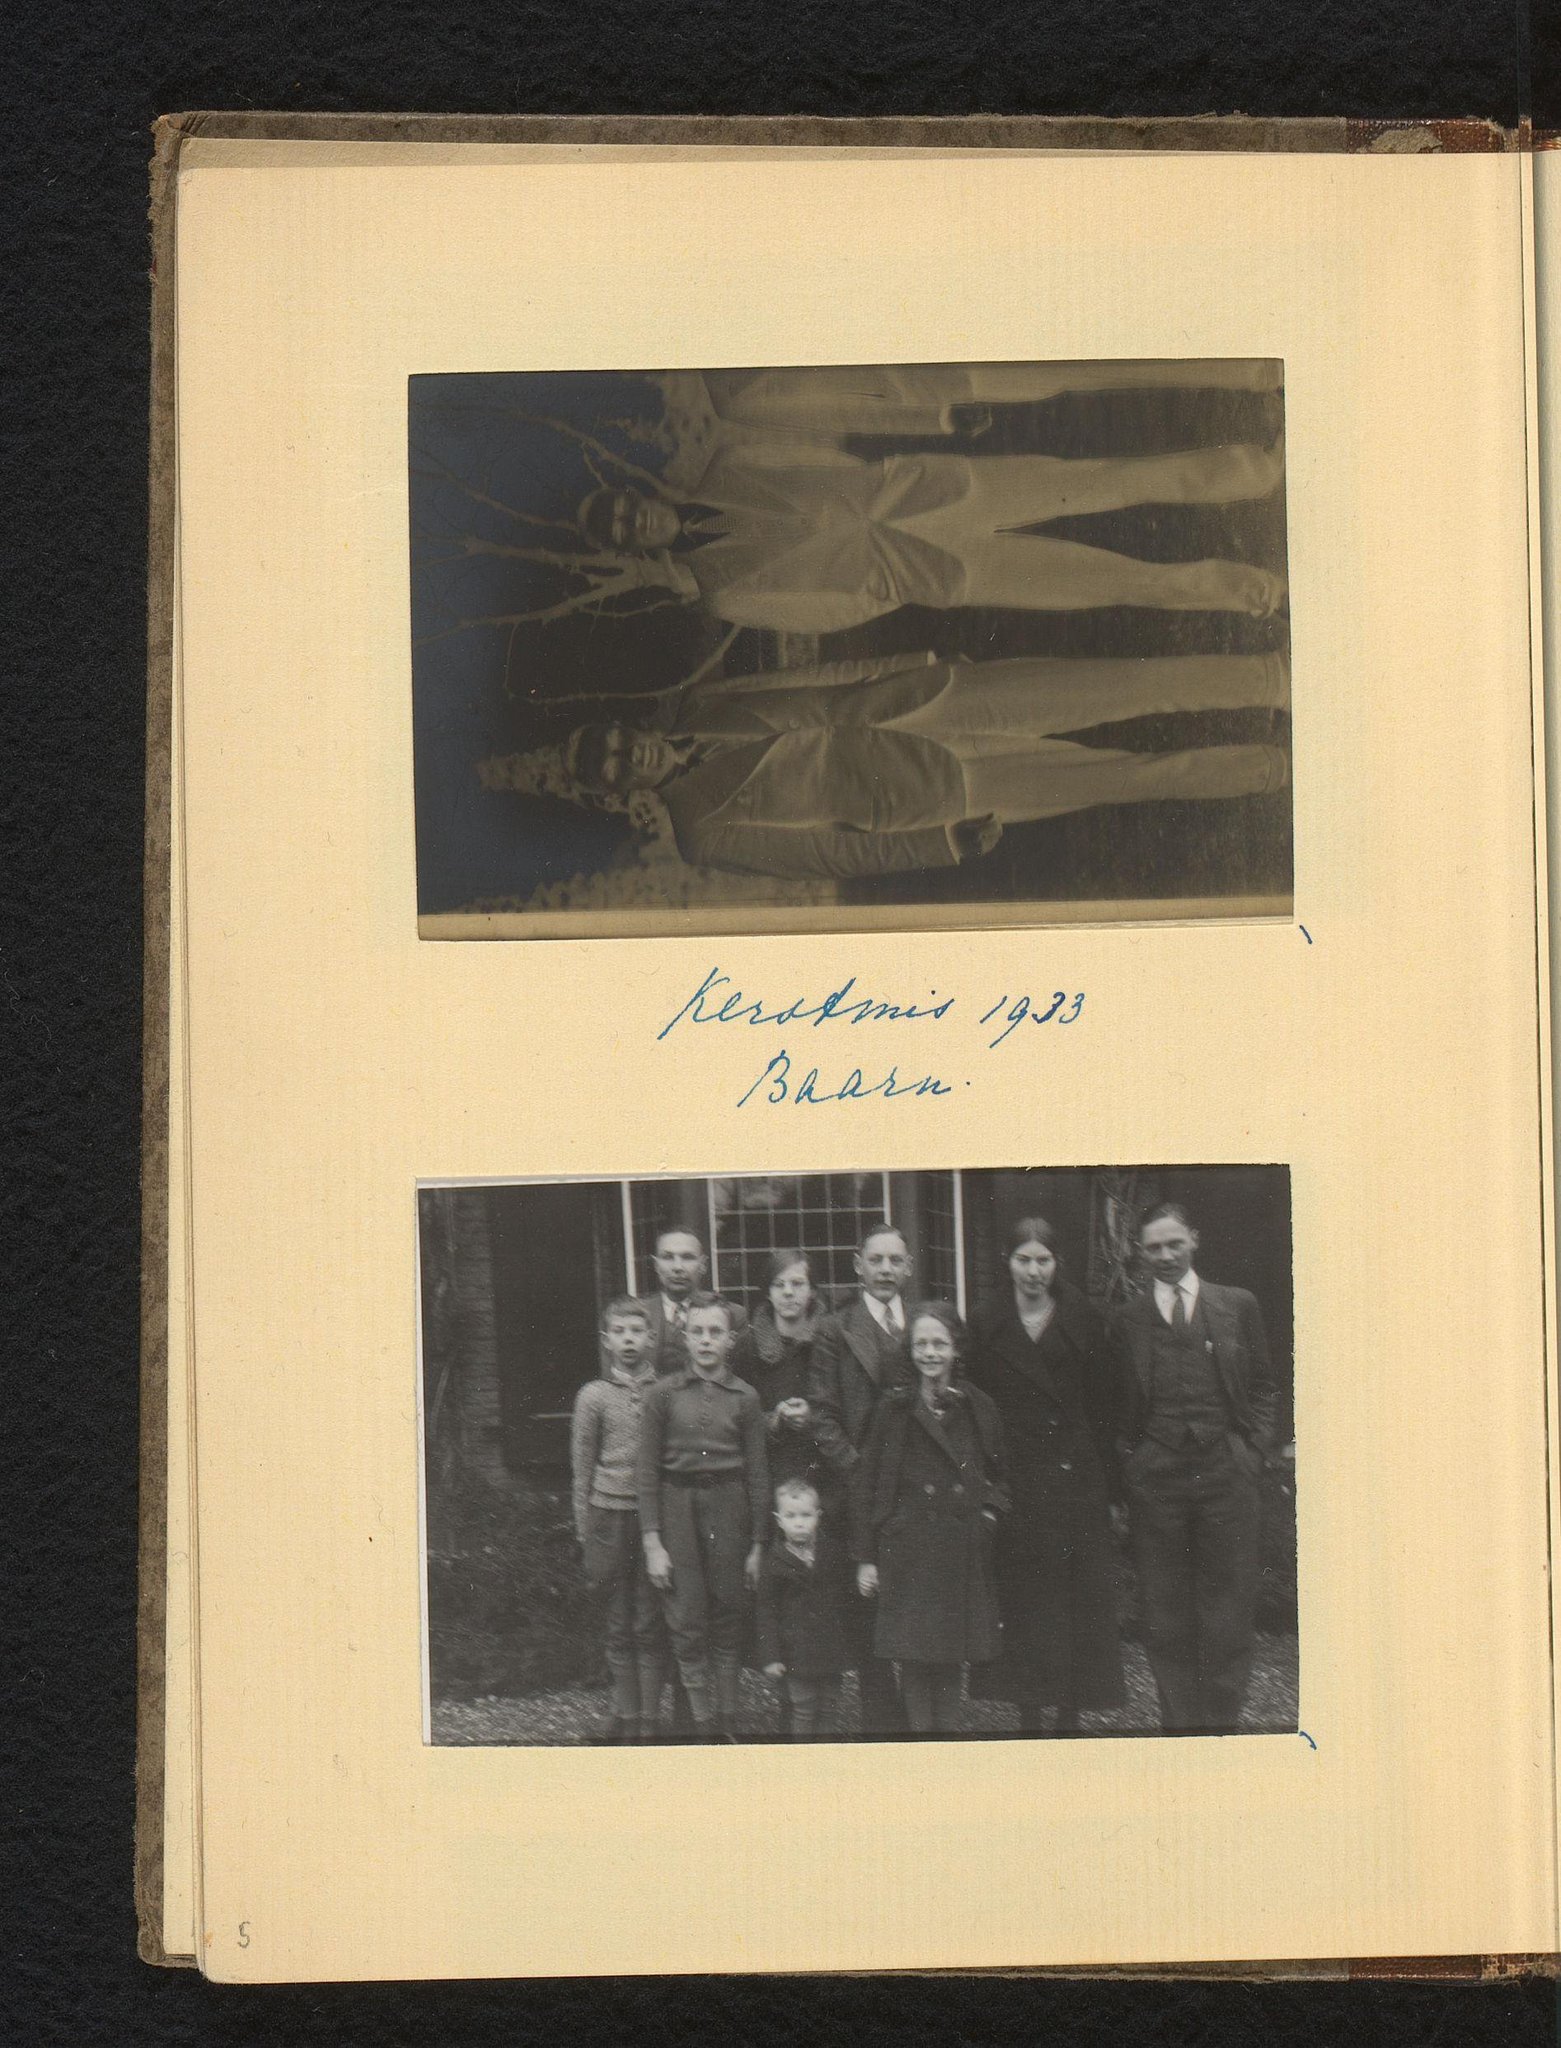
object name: photograph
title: Kerstmis 1933 Baarn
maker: Anonymous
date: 1912-1933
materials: paper, film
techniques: gelatin silver negative, gelatin silver print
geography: baarn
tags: family life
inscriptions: inscription: ‘Kerstmis 1933/ Baarn’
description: Deze foto's maken deel uit van een album.